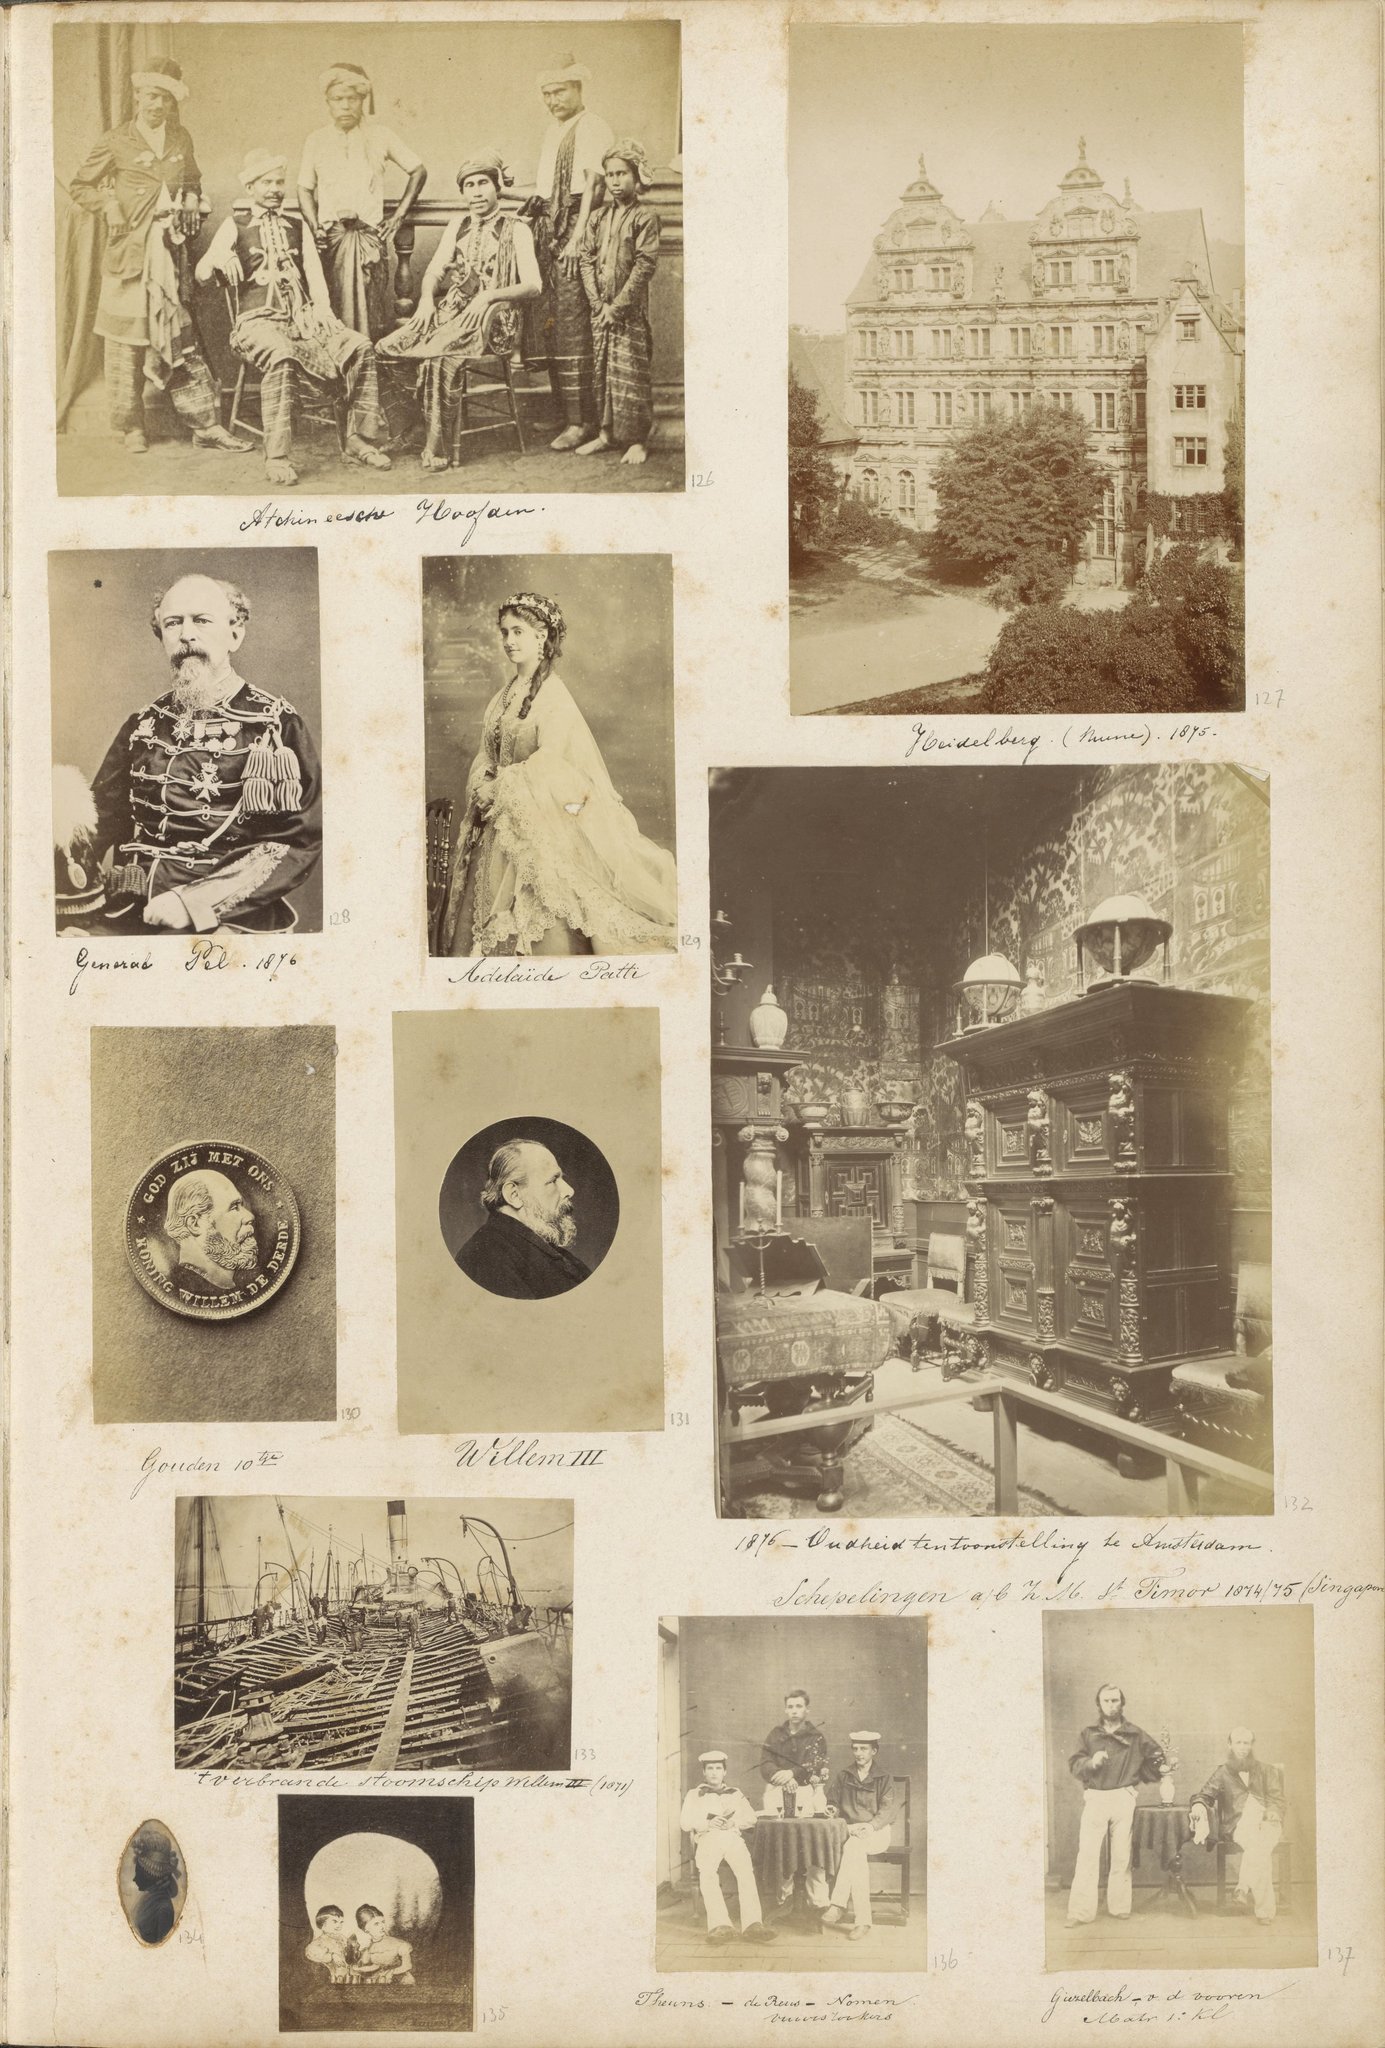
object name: album leaf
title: Portret van operazangeres Adelina Patti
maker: Anonymous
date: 1870-1880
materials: paper, photographic support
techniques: albumen print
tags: opera-singer (female)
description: Onderdeel van Fotoalbum van Robert Daniel Crommelin (1841-1907).